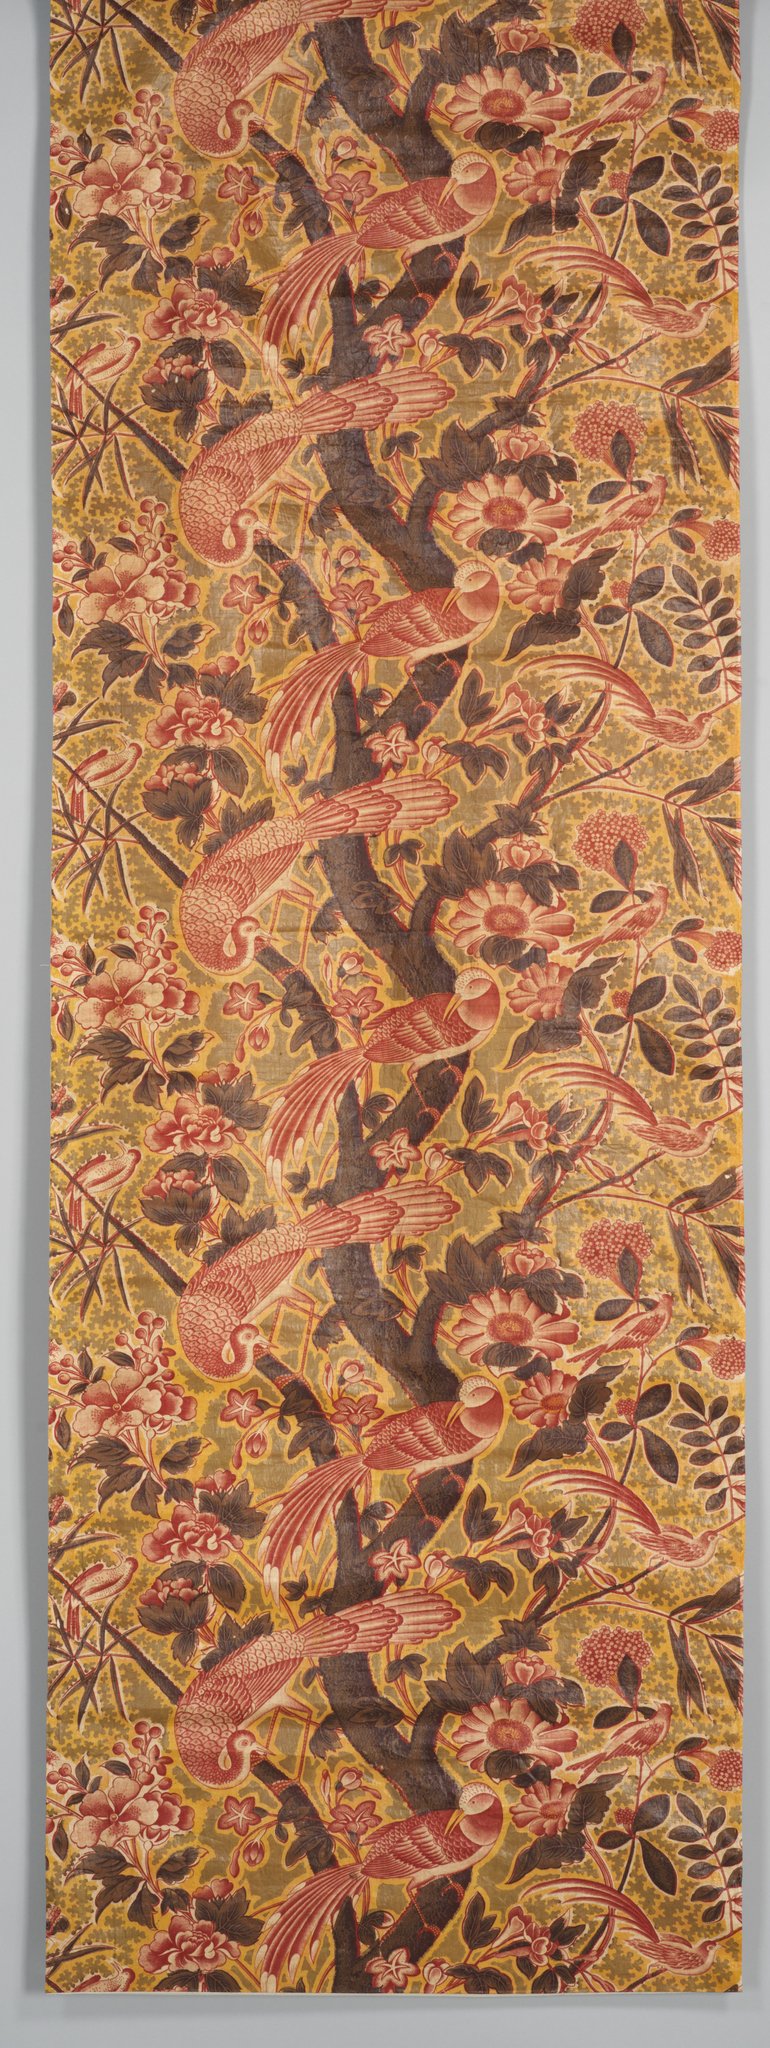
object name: piece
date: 1825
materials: cotton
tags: birds,flowers